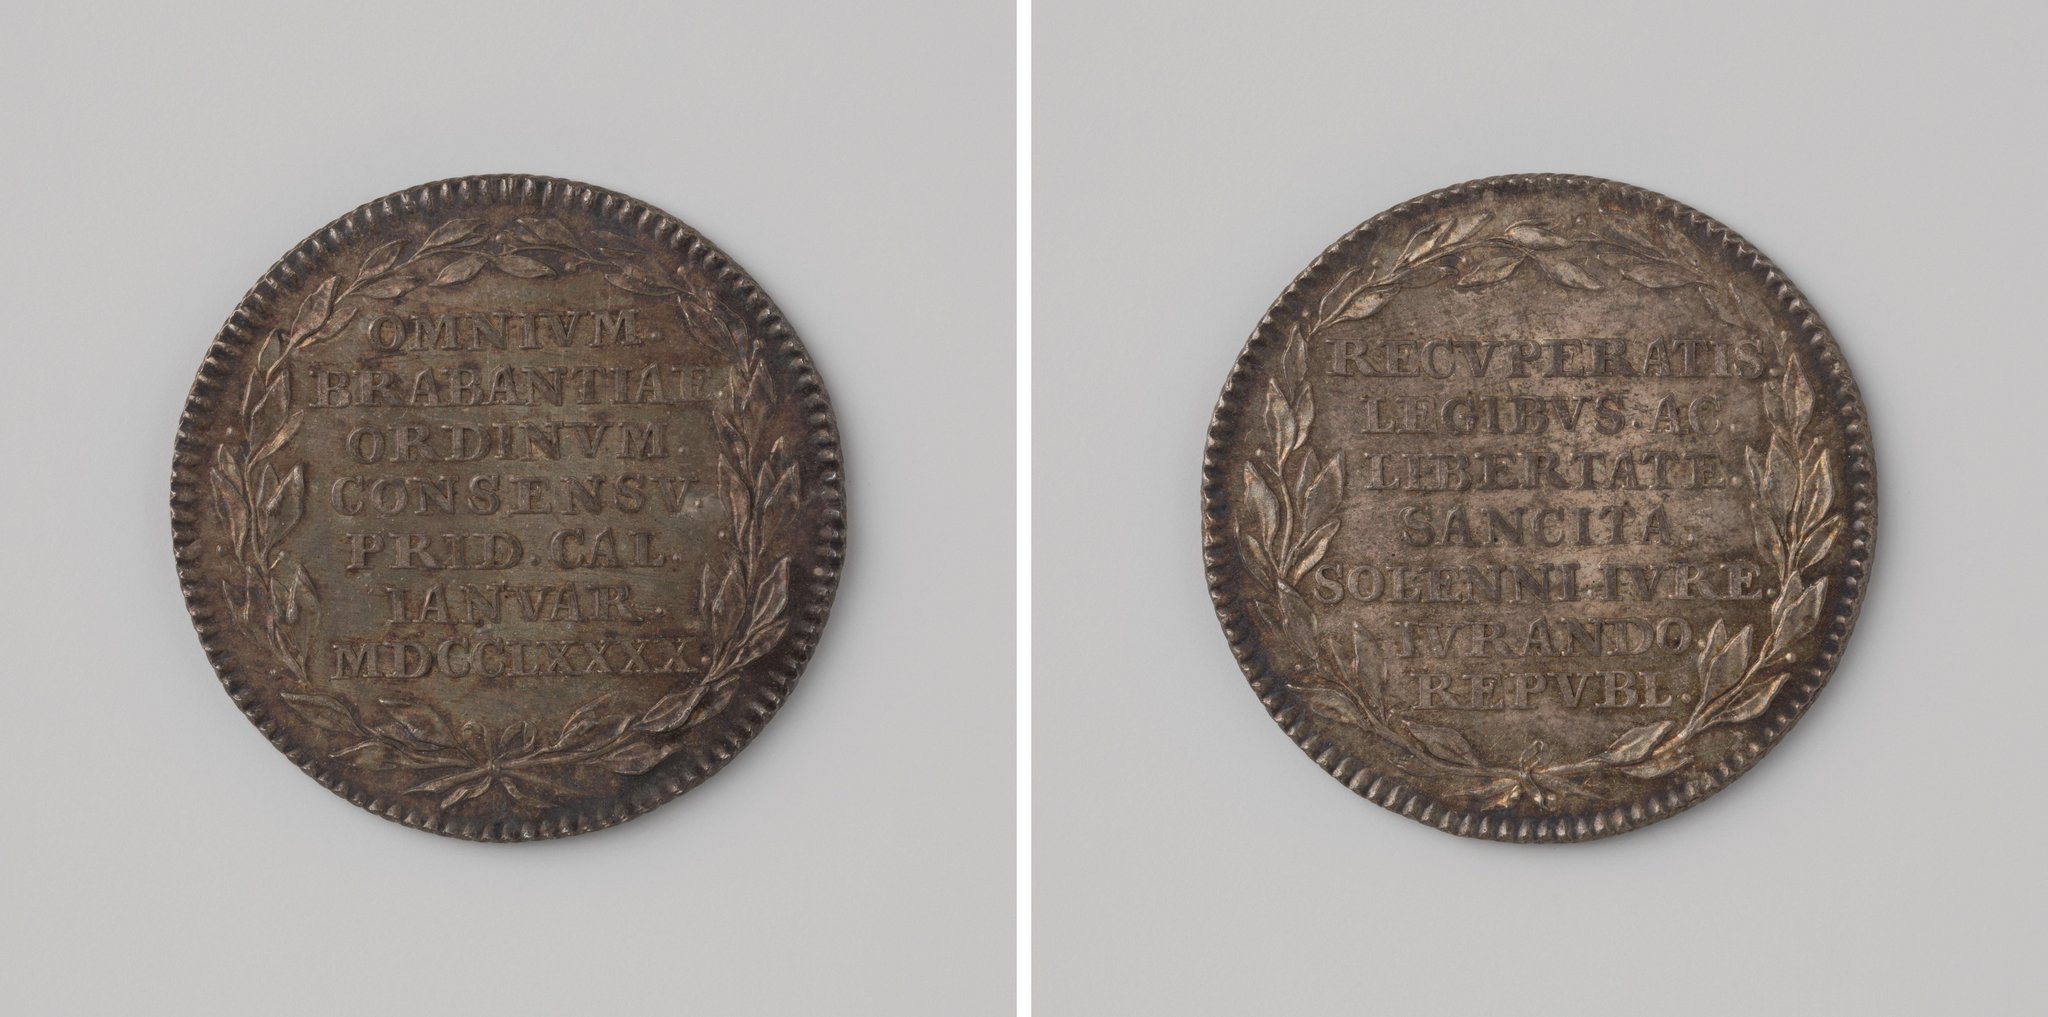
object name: history medal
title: Brabant vrij verklaard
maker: theodorus victor van berckel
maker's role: mintmaster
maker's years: 1739-1808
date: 1790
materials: silver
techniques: striking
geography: brabant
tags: brabant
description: Zilveren penning. Voorzijde: opschrift binnen lauwerkrans. Keerzijde: opschrift binnen lauwerkrans